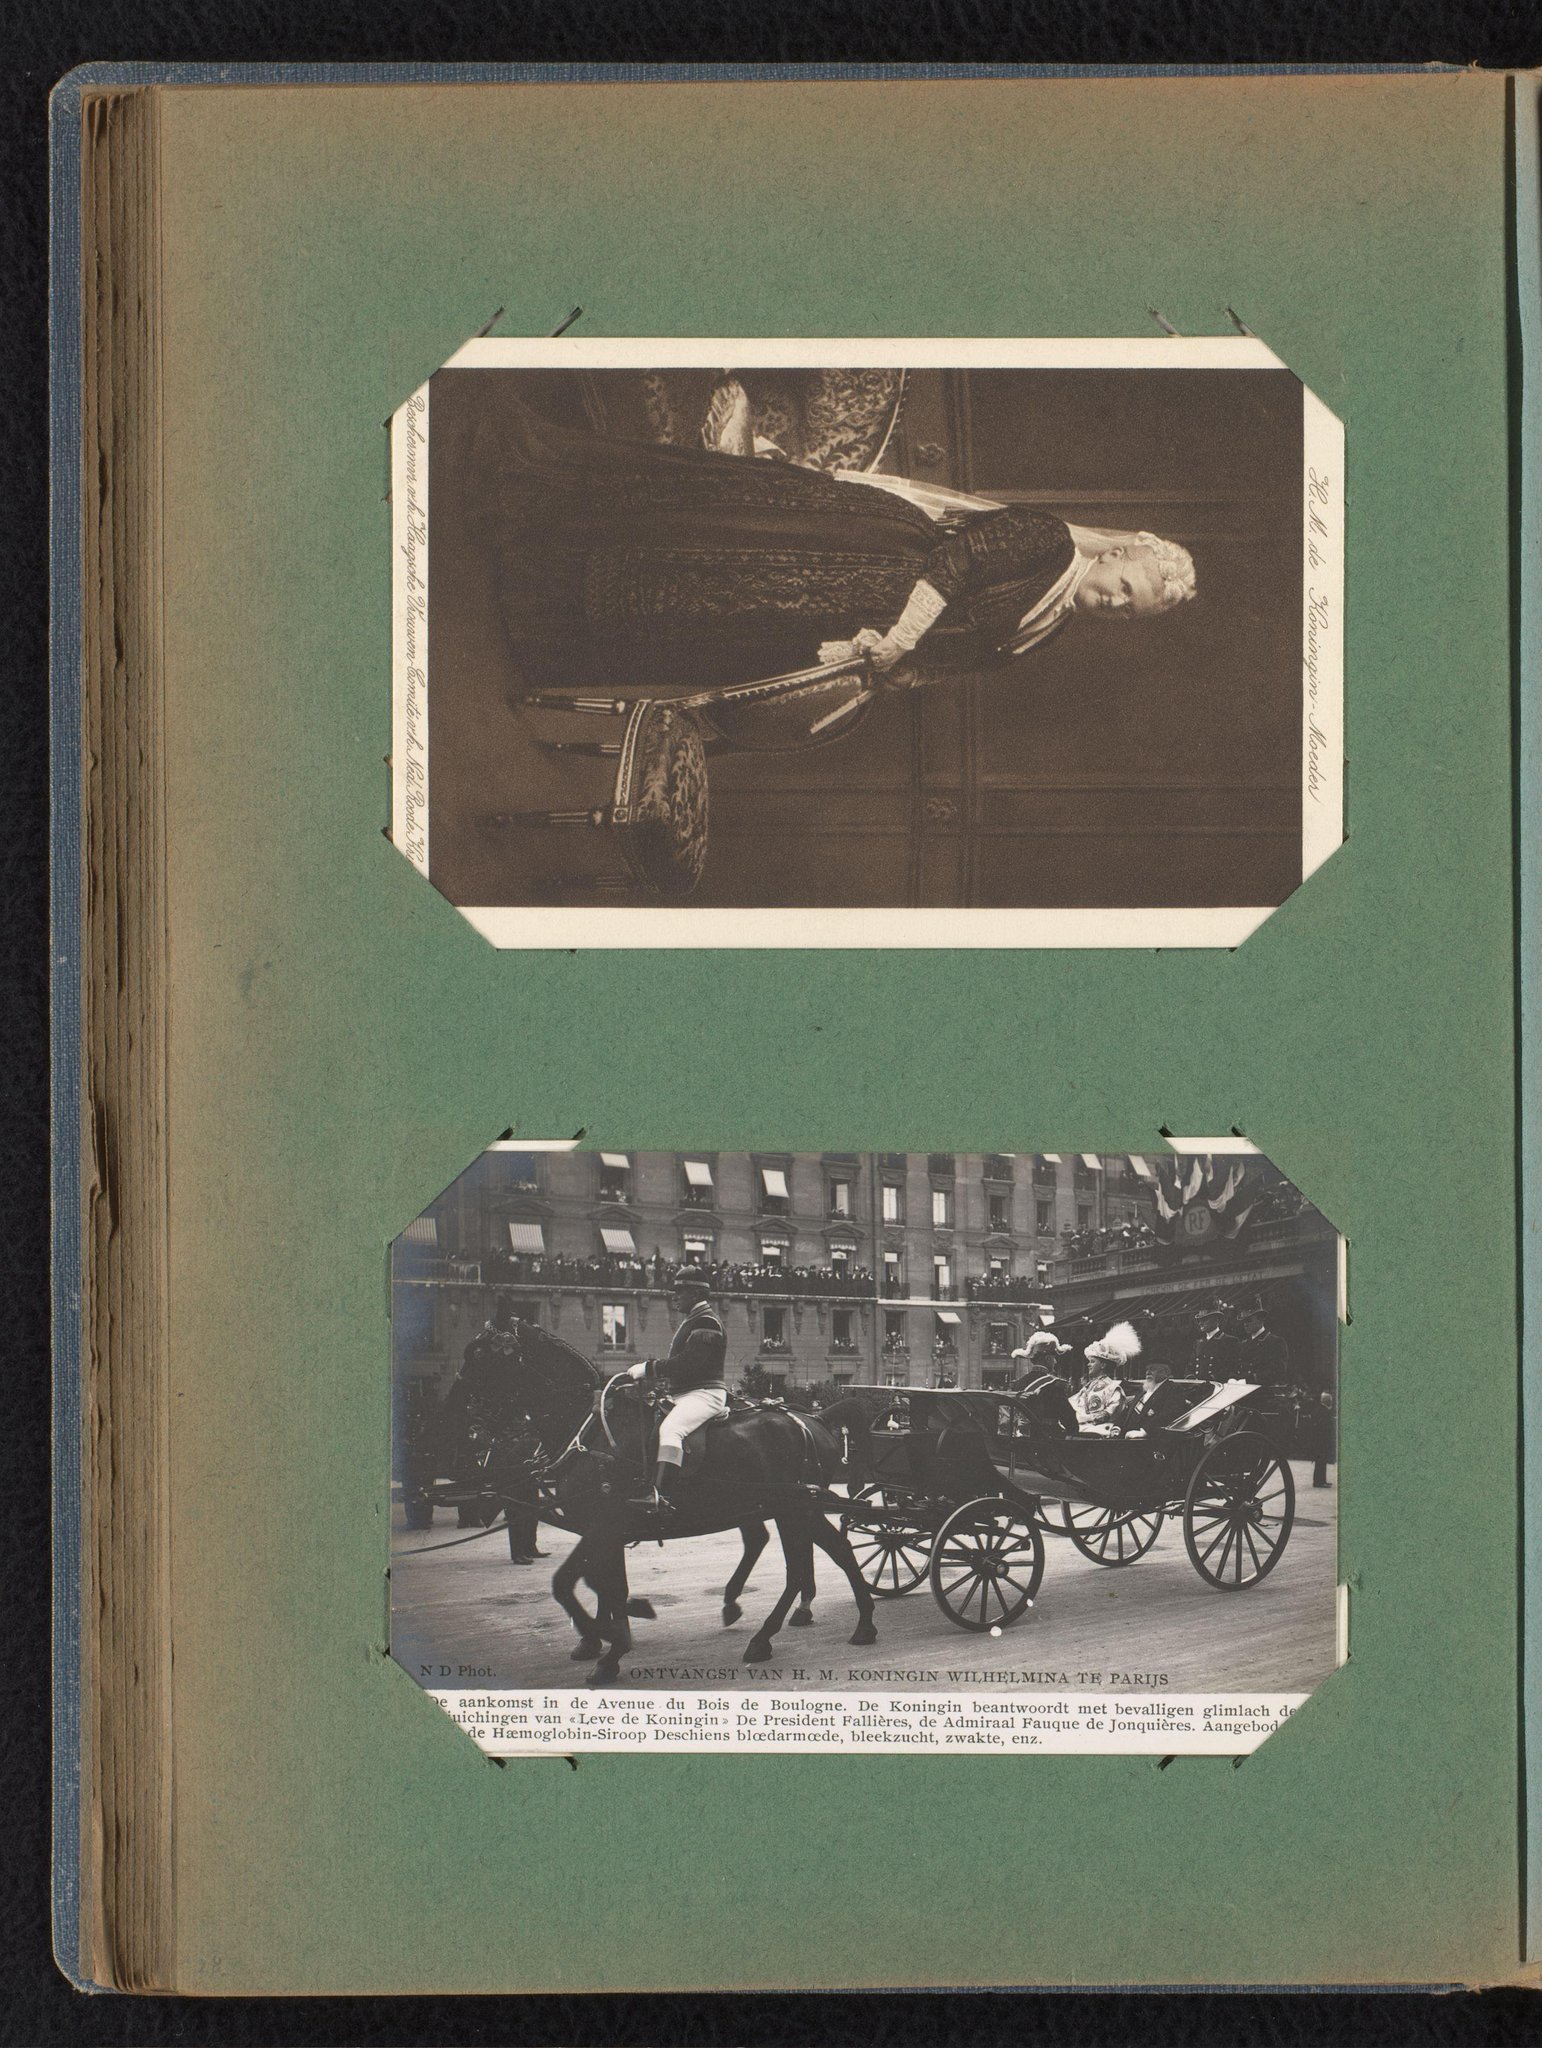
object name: ansichtkaart, prentbriefkaart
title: Twee prentbriefkaarten van een portret van koningin-moeder Emma en een bezoek van koningin Wilhelmina aan Parijs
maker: Anonymous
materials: paper, cardboard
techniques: gelatin silver print, rotogravure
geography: paris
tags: wilhelmina of the netherlands, hendrik (prins der nederlanden (1876-1934)), the hague, emma (queen consort of the netherlands), historical persons - bb - woman, queen, four-wheeled vehicle drawn by two animals, paris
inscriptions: inscription: ‘Ontvangst van H.M. Koningin Wilhelmina te Parijs/ De aankomst (...) zwakte, enz.’, inscription: ‘H.M. de Koningin-Moeder/ Beschermvr. v.h. Haagsche Vrouwen-Comité v.h. Ned. Roode Kruis’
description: Deze foto en prent maken deel uit van een album.